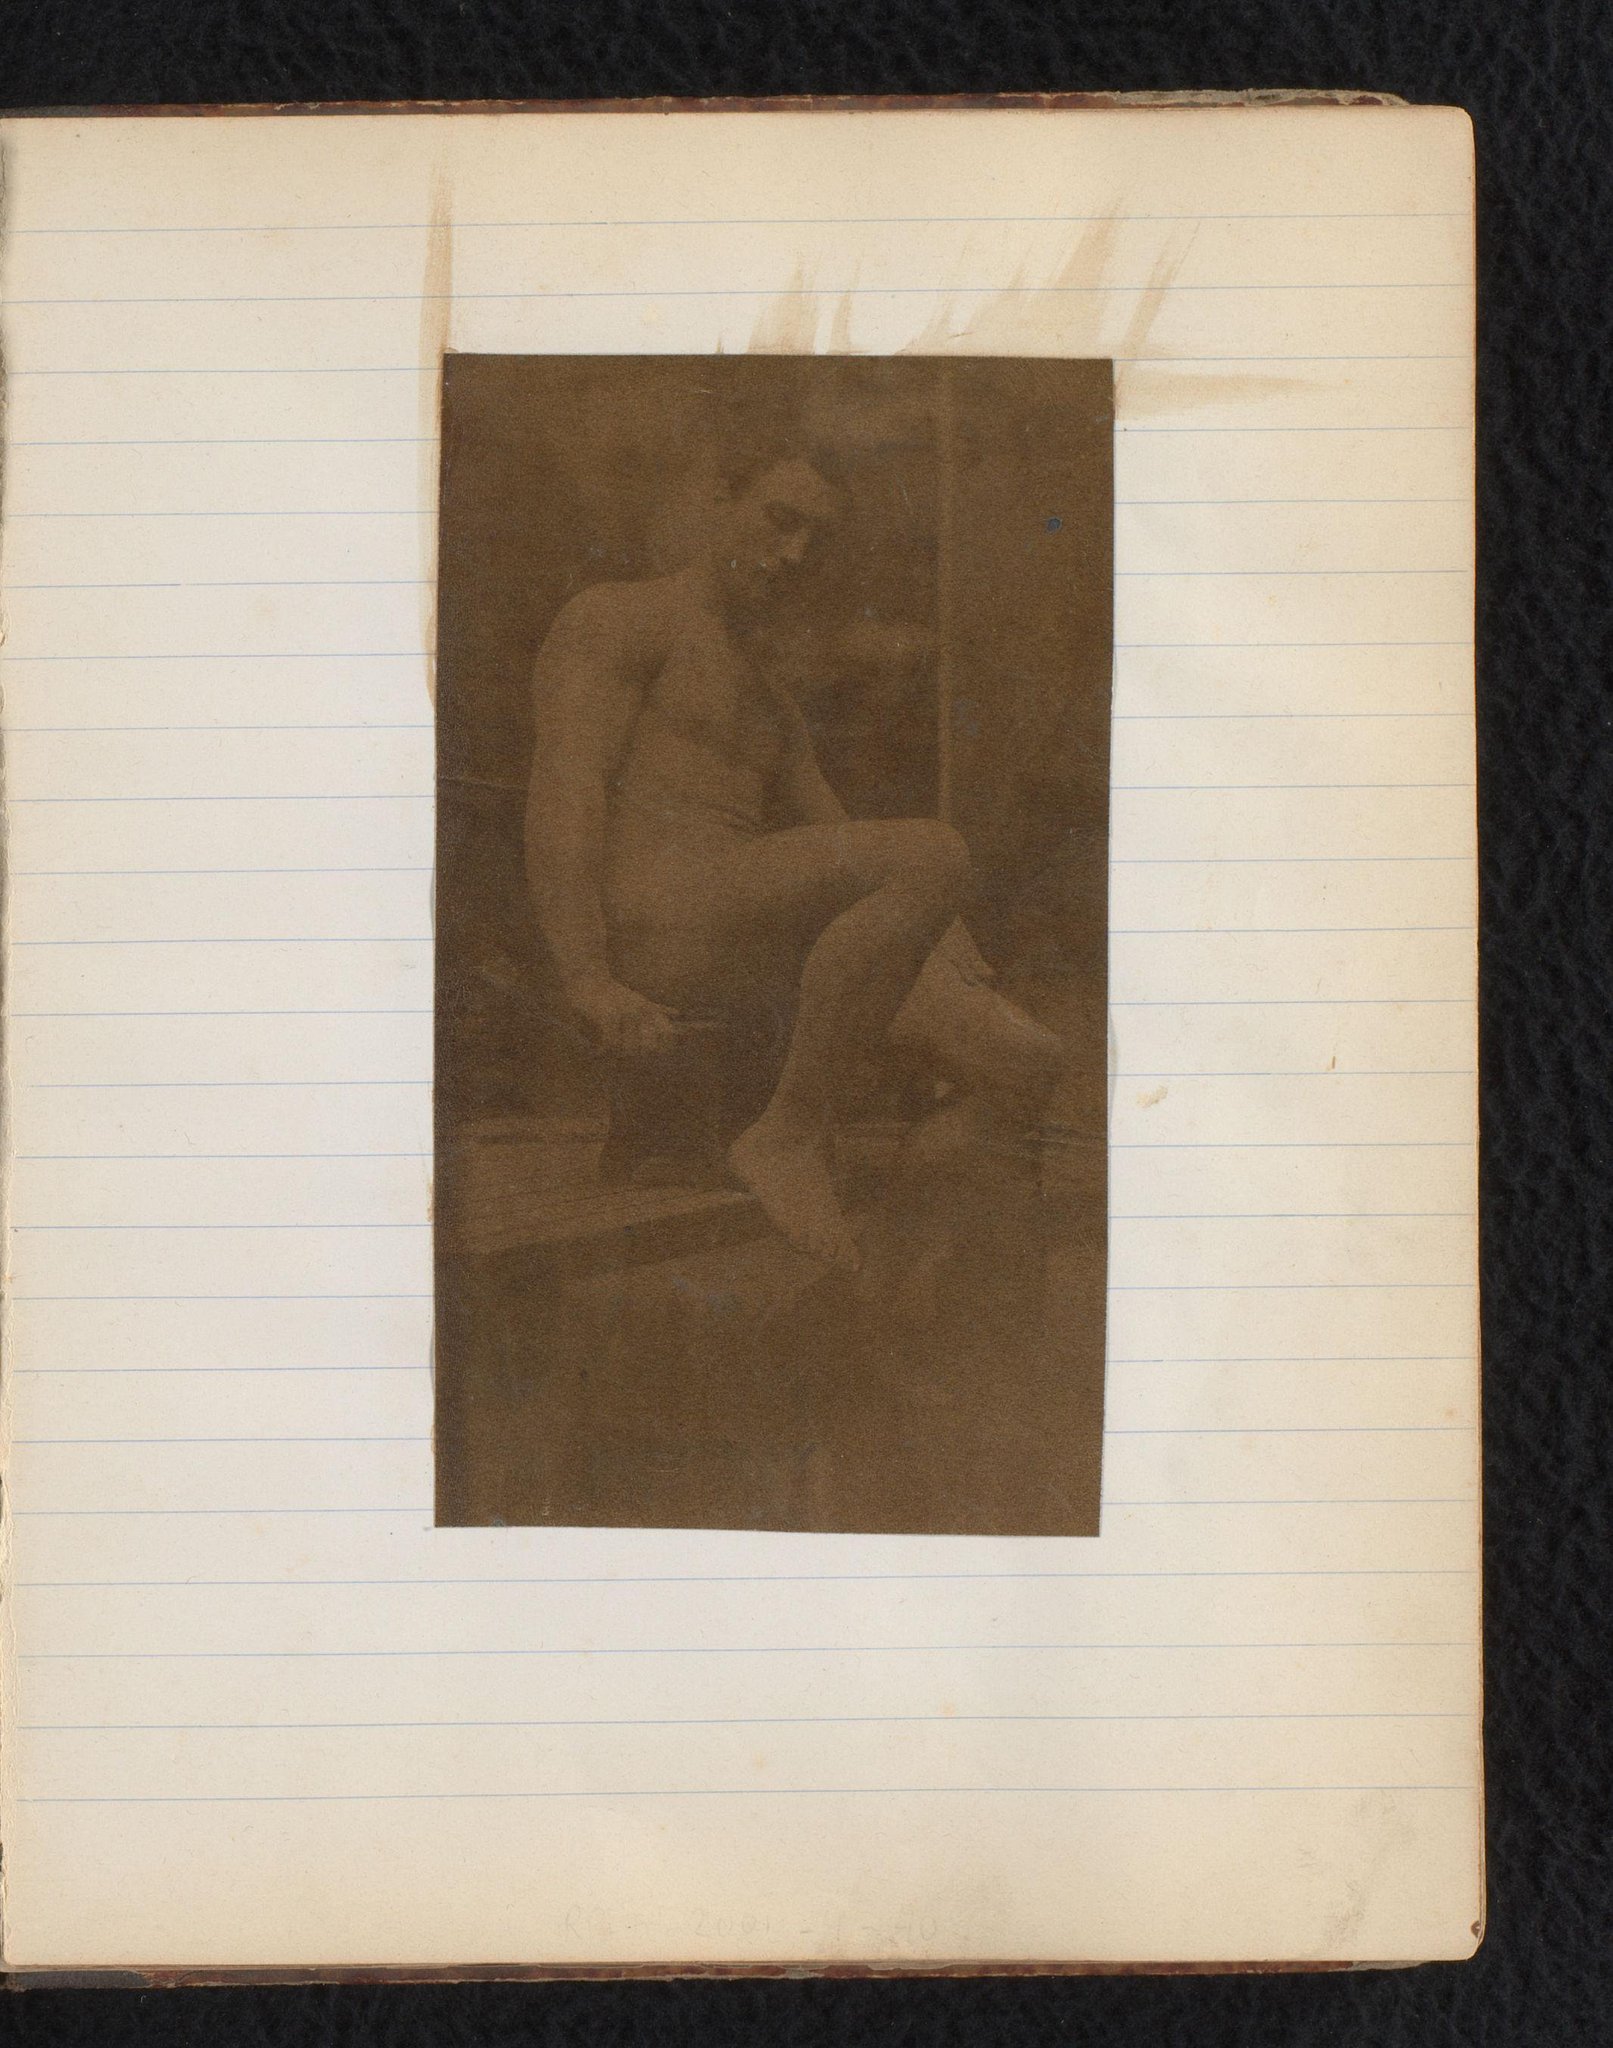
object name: album leaf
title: Studie van een mannelijk naaktmodel, van opzij gezien, in het atelier van Jacques de Lalaing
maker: jacques lalaing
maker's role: painter, sculptor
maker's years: 1858-1917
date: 1883-1914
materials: photographic support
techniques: albumen print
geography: brussels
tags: the (nude) human figure; 'corpo humano' (ripa) (+ sideview, profile), adult man, artist (in general) working from nude model